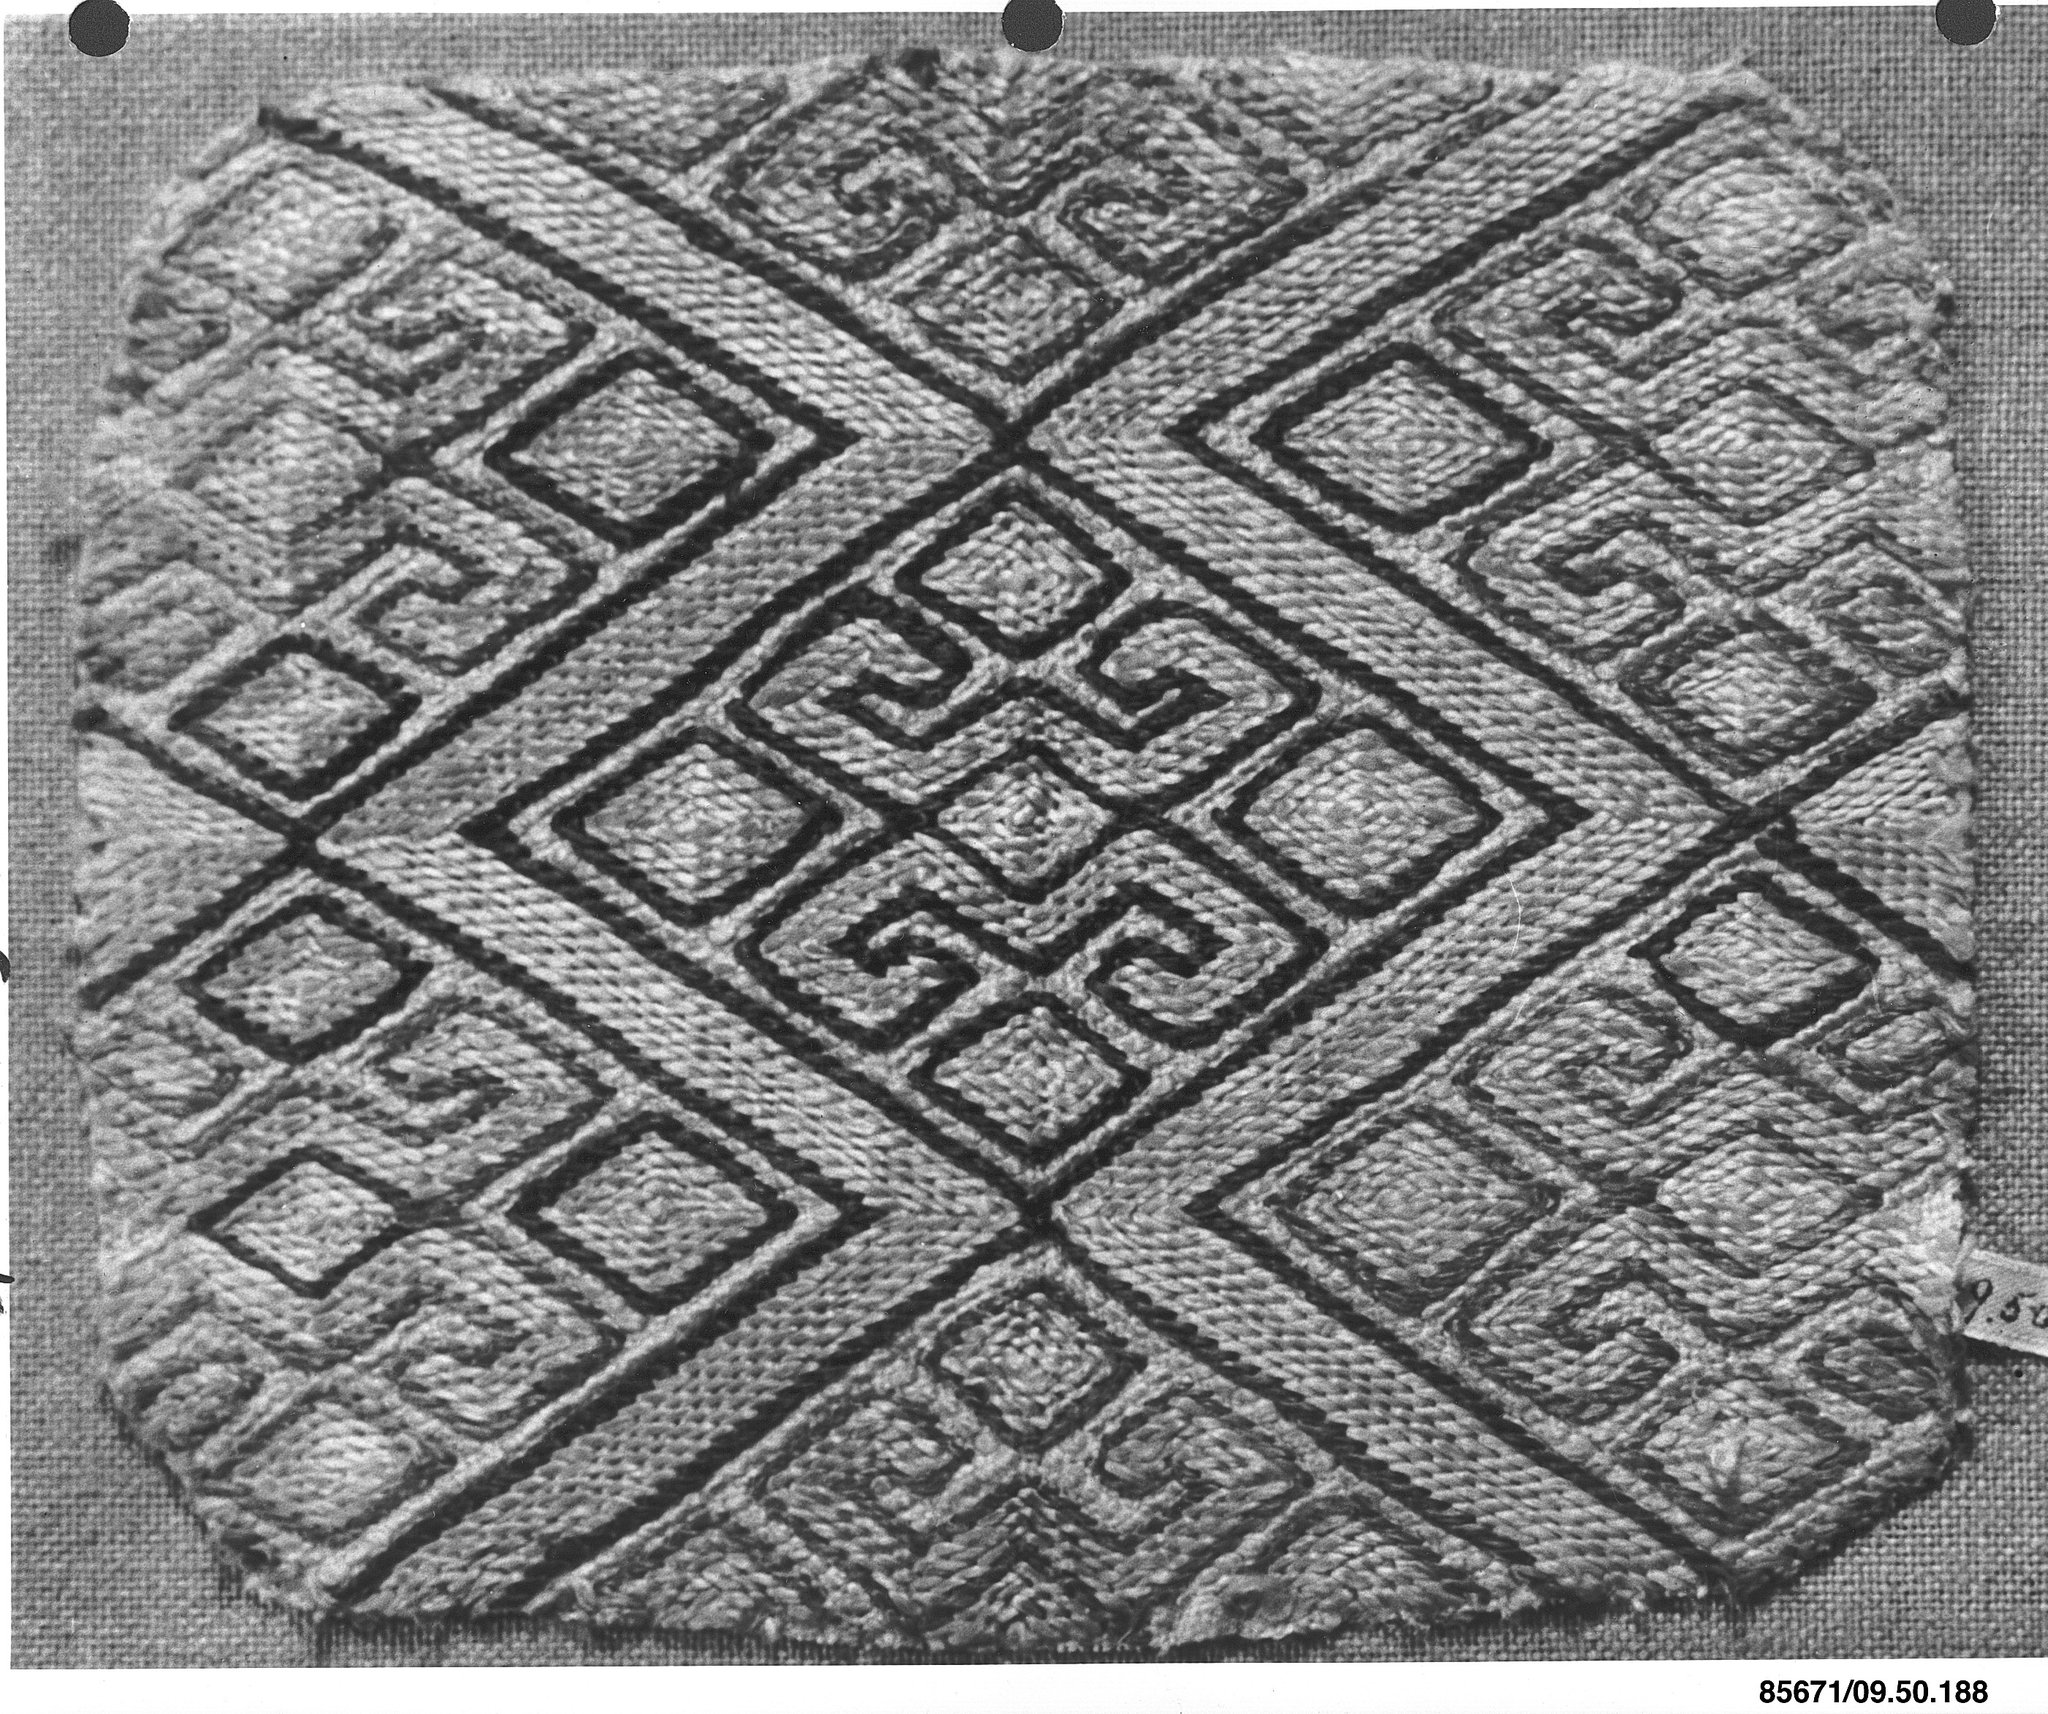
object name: costume fragment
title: Peasant costume fragment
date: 1701-1900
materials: canvas